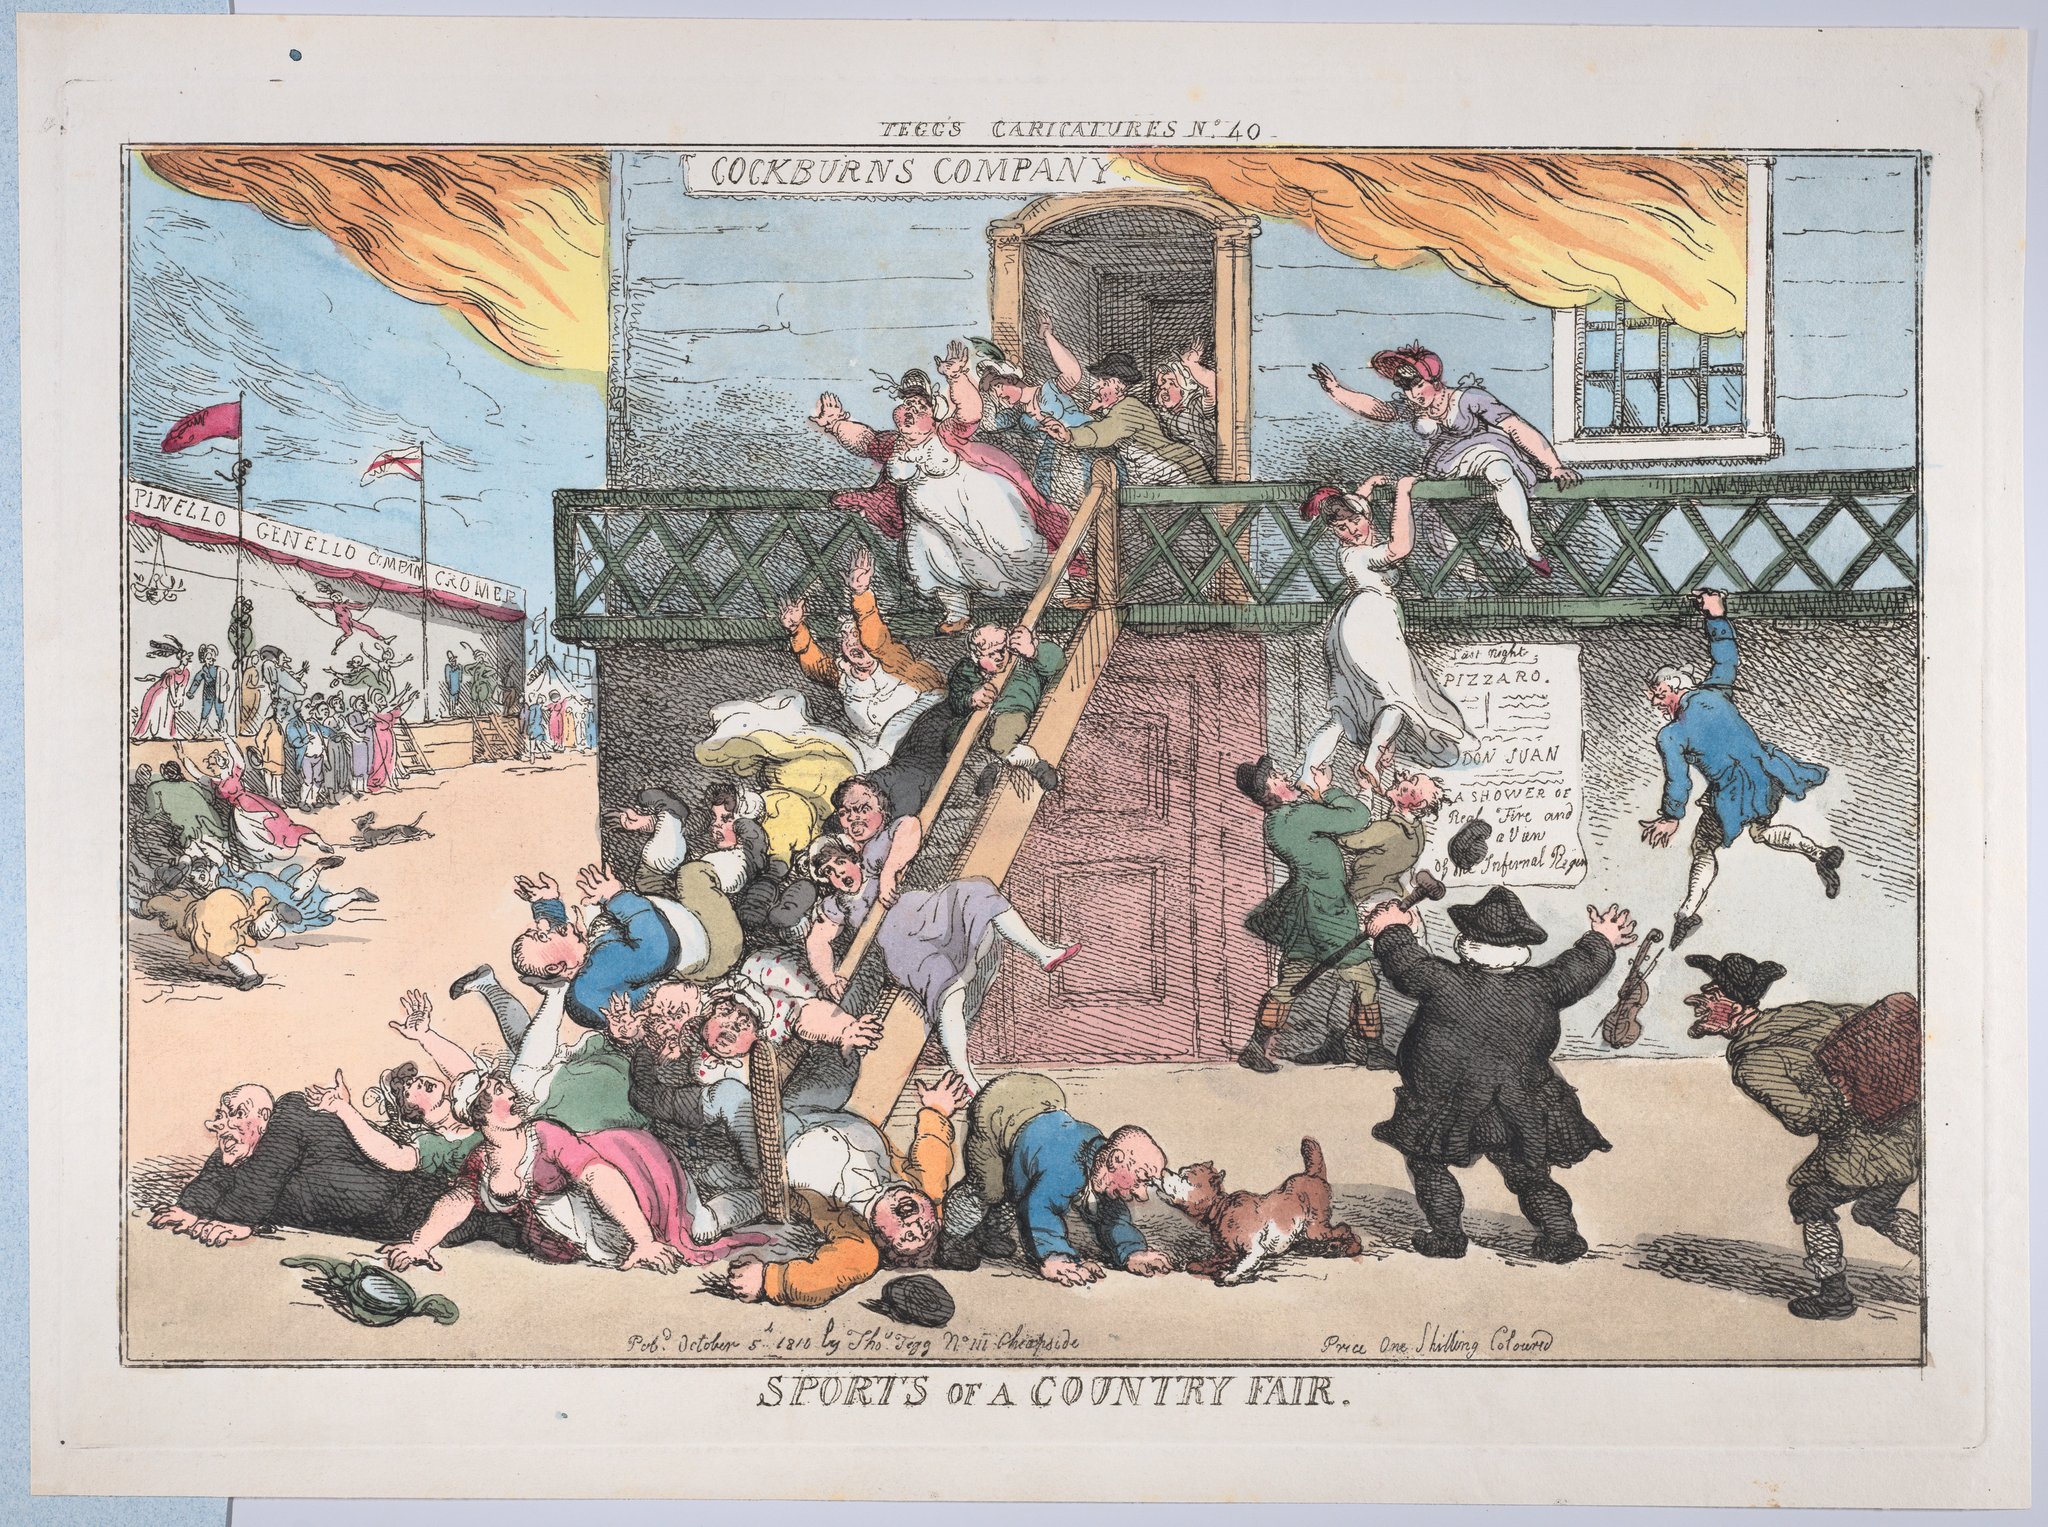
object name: print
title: Sports of a Country Fair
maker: thomas rowlandson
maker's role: artist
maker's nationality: british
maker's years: 1757-1827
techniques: etching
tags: satire,men,women,fire